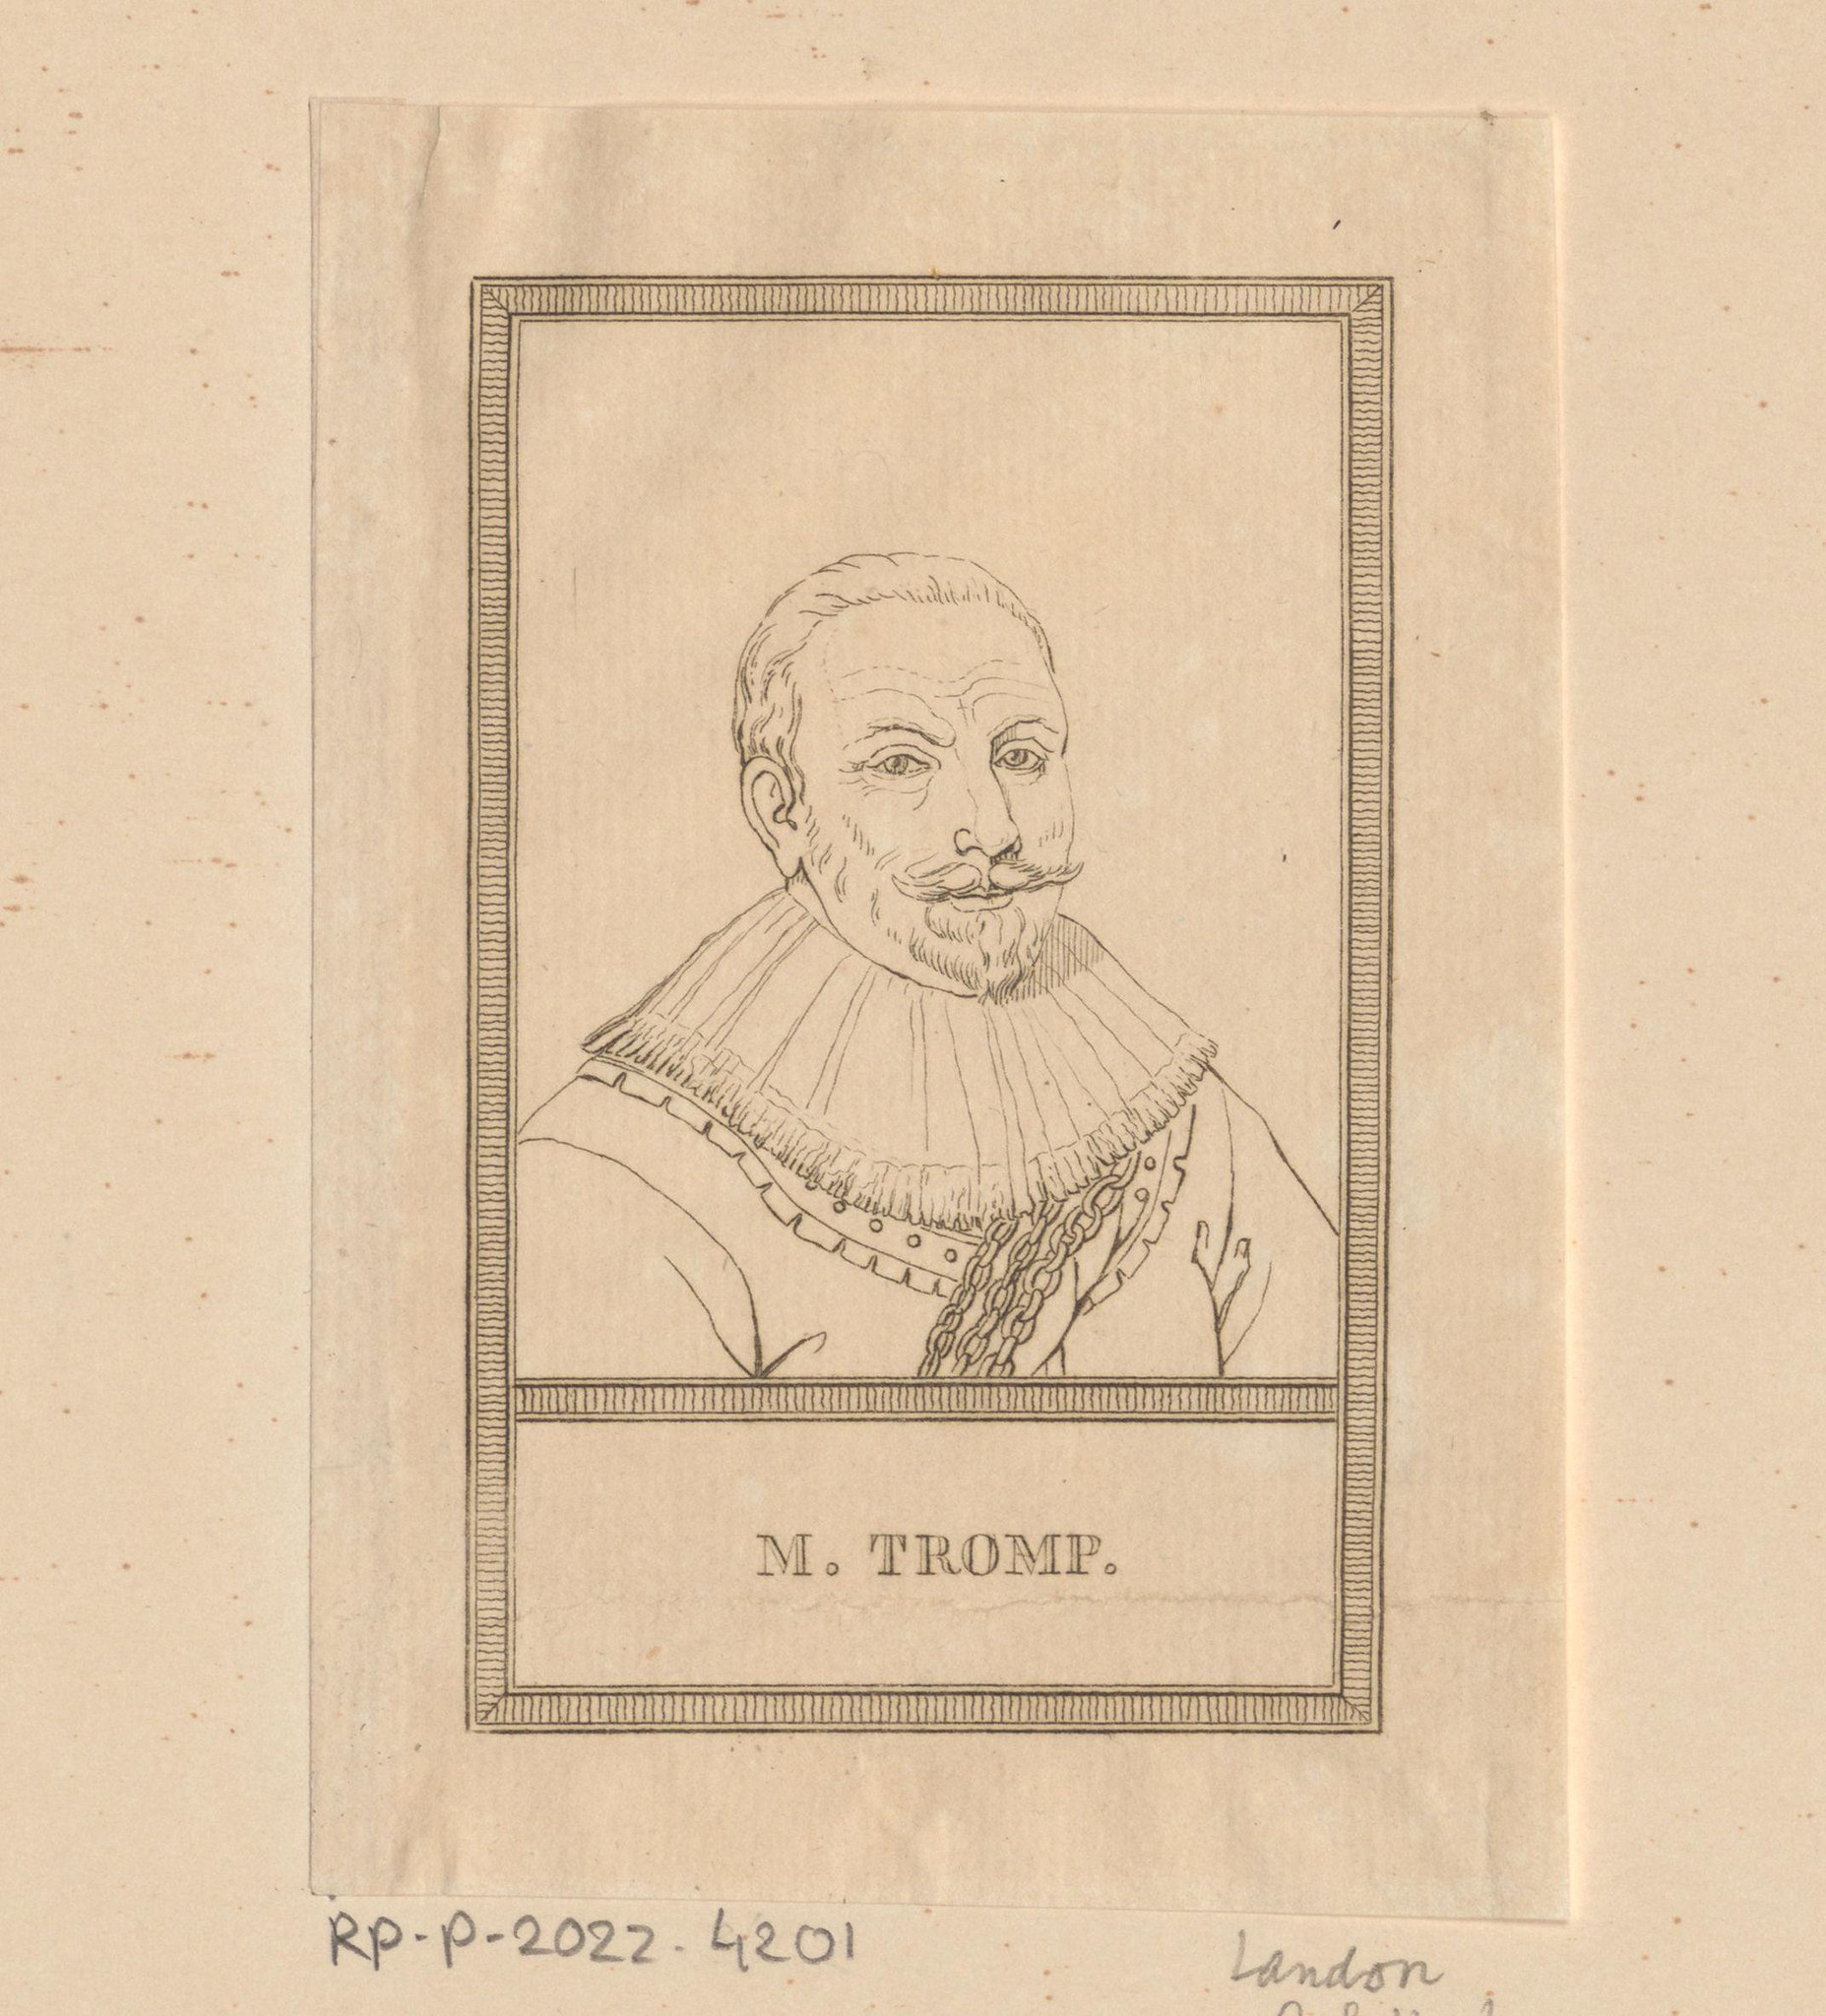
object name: print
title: Portret van Maarten Harpertszoon Tromp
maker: Anonymous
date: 1805-1811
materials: paper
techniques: etching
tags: brielle, maarten harpertszoon tromp, historical persons, commander-in-chief, admiral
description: Prent waarschijnlijk uit een deel van: Galerie historique des hommes les plus célèbres (...). Parijs: Charles Paul Landon, 1805-1811.